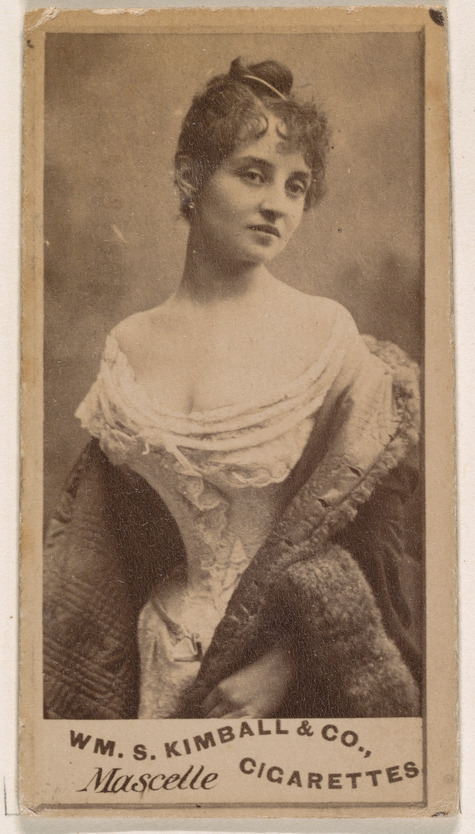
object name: photograph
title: Miss Mascelle, from the Actresses series (N203) issued by Wm. S. Kimball & Co.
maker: william s. kimball & company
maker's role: publisher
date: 1889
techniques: color lithograph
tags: portraits,women,actresses